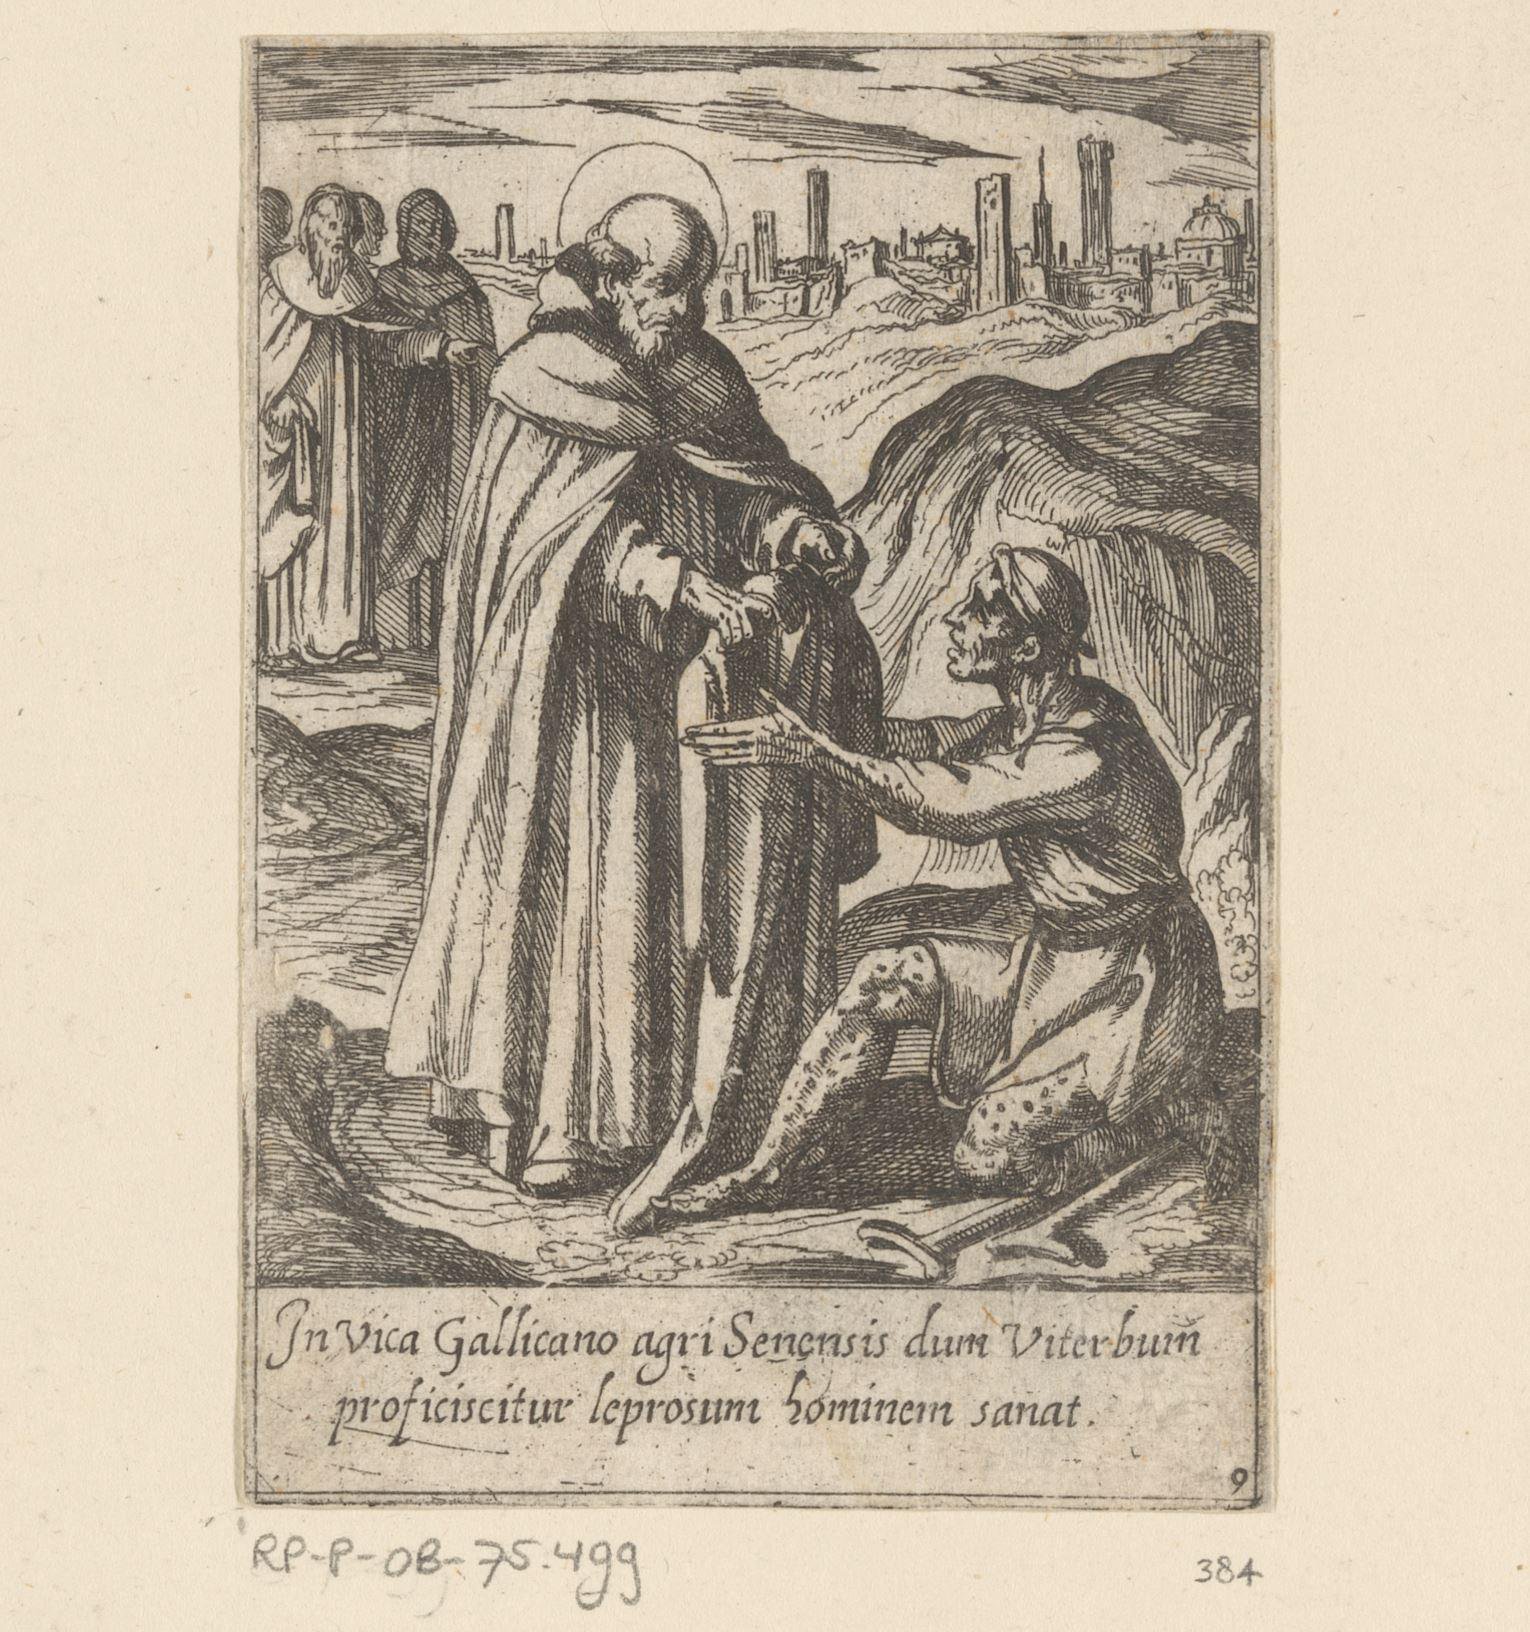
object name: print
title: Vita B. Philippi Benicii Florent. ord. servor B. Mariae virginis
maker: antonio tempesta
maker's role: draughtsman, painter, print maker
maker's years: 1555-1630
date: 1591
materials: paper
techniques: etching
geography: rome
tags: clergyman, miraculous activities and events ~ st. philip benizzi, prior general of the order of the servites, philip benizzi of florence; possible attributes: book, cross, lily, tiara at his feet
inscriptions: collector's mark: Lugt 240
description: De heilige Philippus geneest een leproos en geeft hem een mantel. Op de achtergrond een stadsgezicht. Tekst in het Latijn in ondermarge. Genummerd rechtsonder: 9.